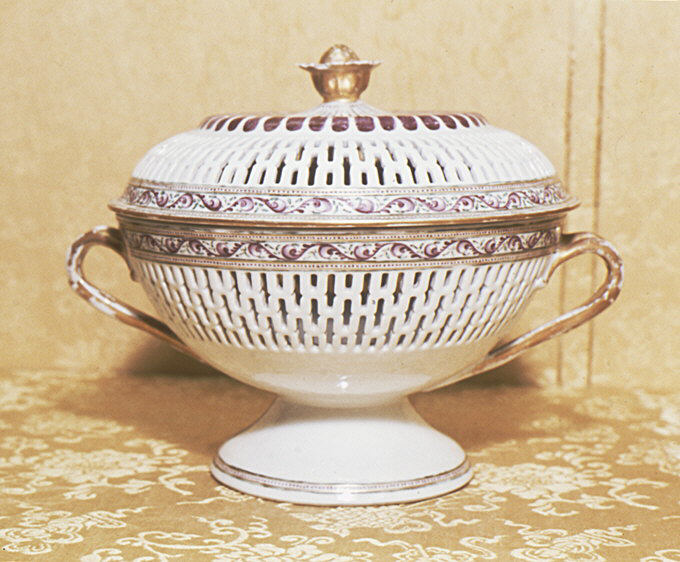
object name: chestnut bowl with cover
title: Pair of chestnut bowls with covers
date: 1785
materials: hard paste porcelain